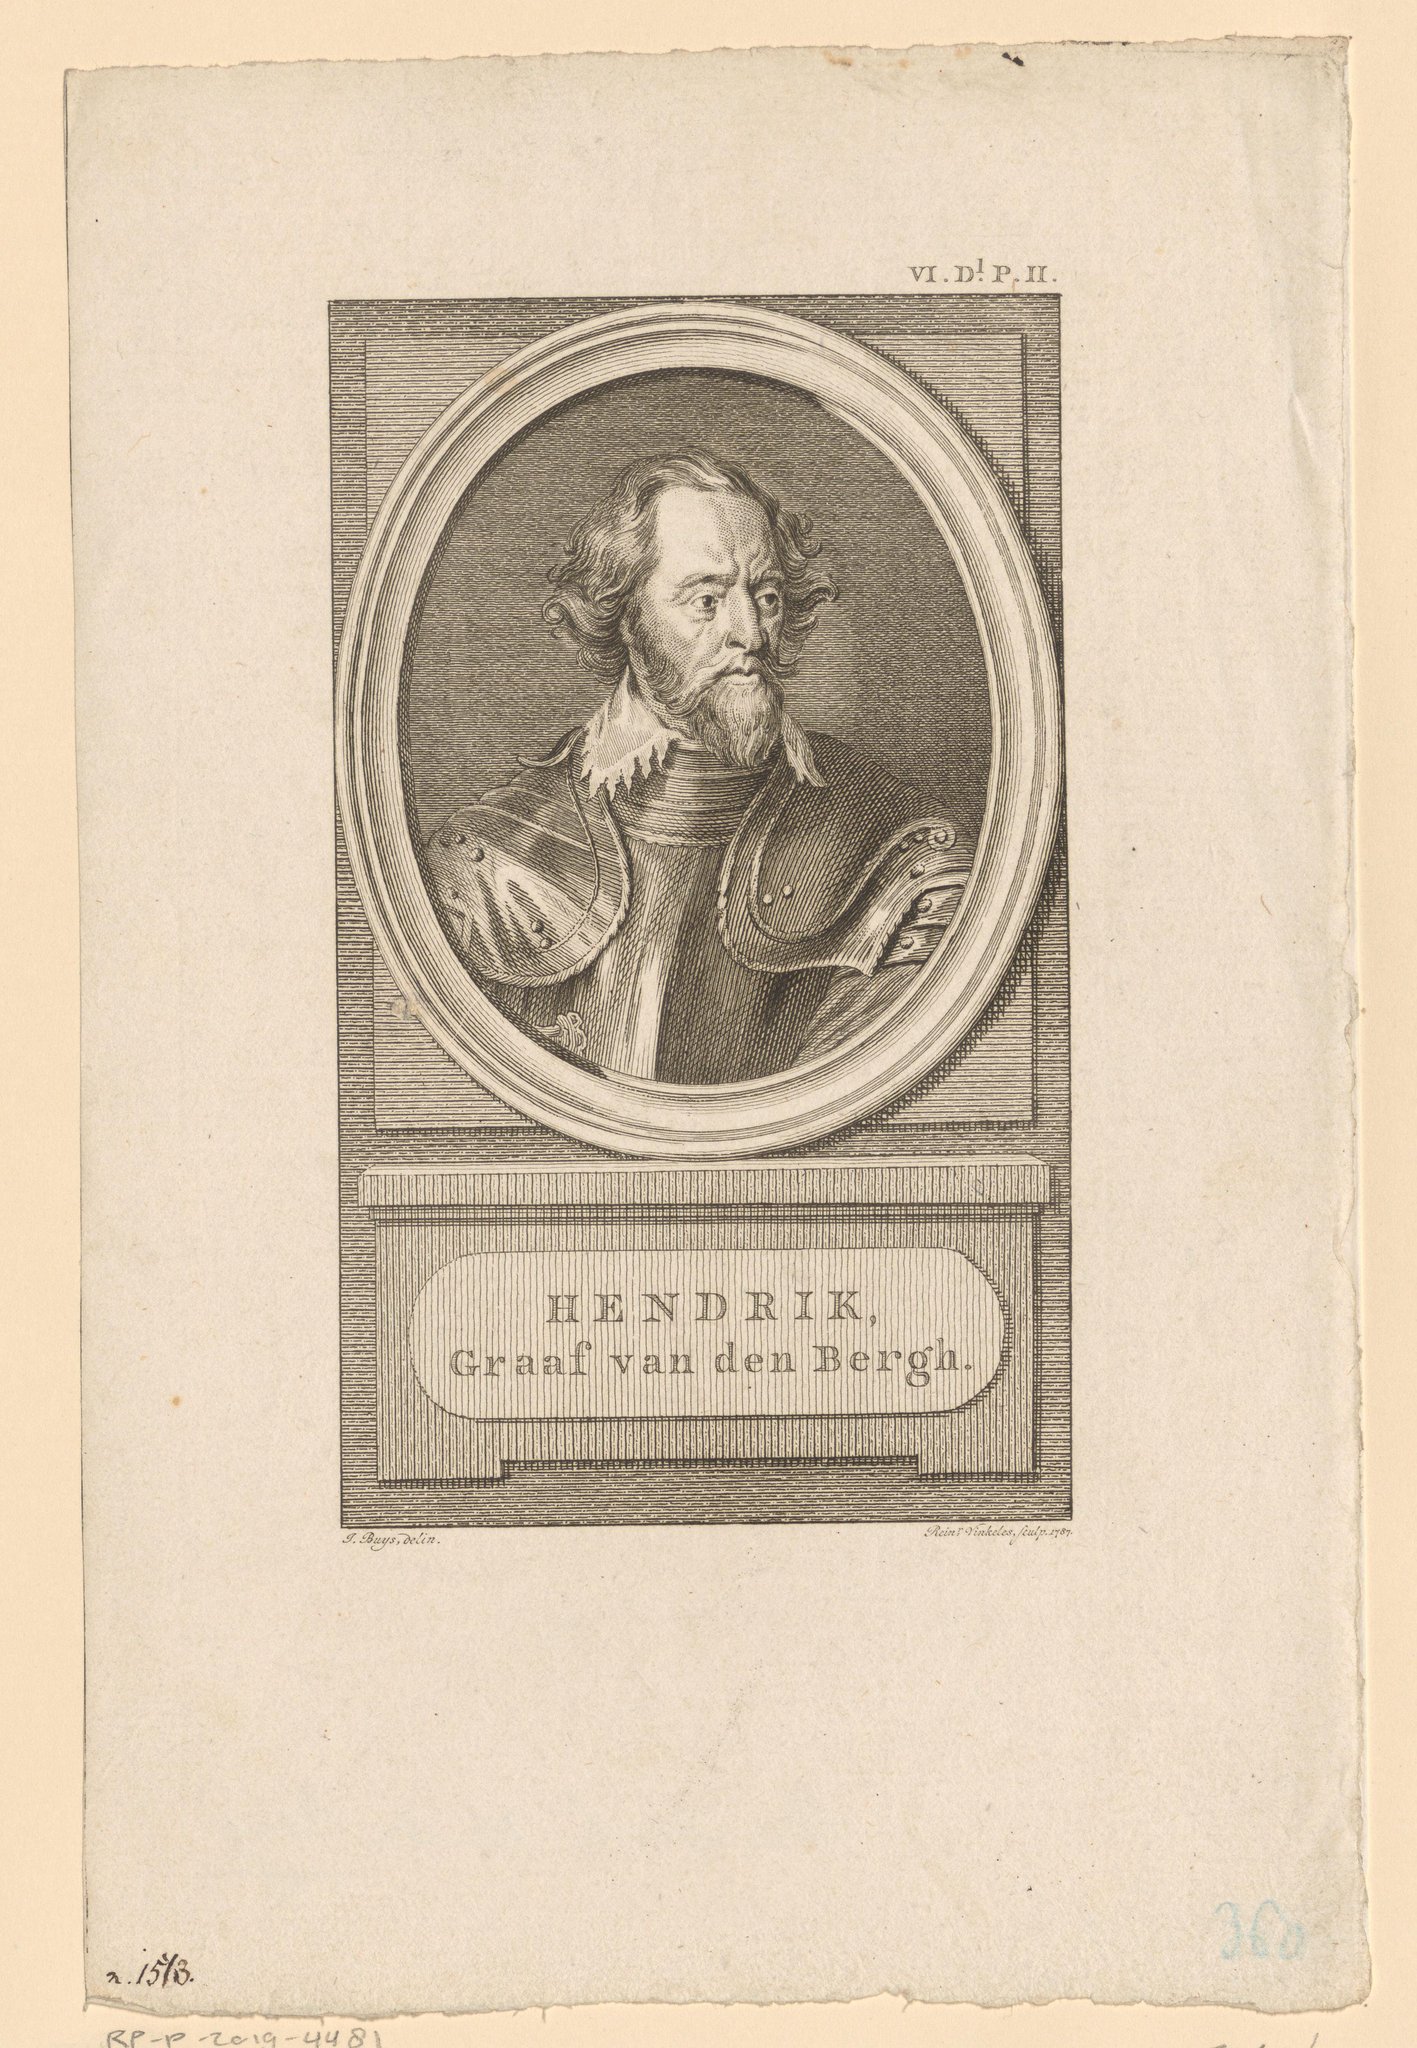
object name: book illustration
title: Portret van Hendrik, graaf van den Bergh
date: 1787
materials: paper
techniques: engraving, etching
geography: amsterdam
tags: armour, historical persons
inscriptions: inscription: ‘n. 1573’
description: Prent uit: Kok, Jacobus. Vaderlandsch woordenboek (...) met kaarten, plaaten en pourtraitten. Amsterdam: Johannes Allart, 1785-1796, dl. 6.